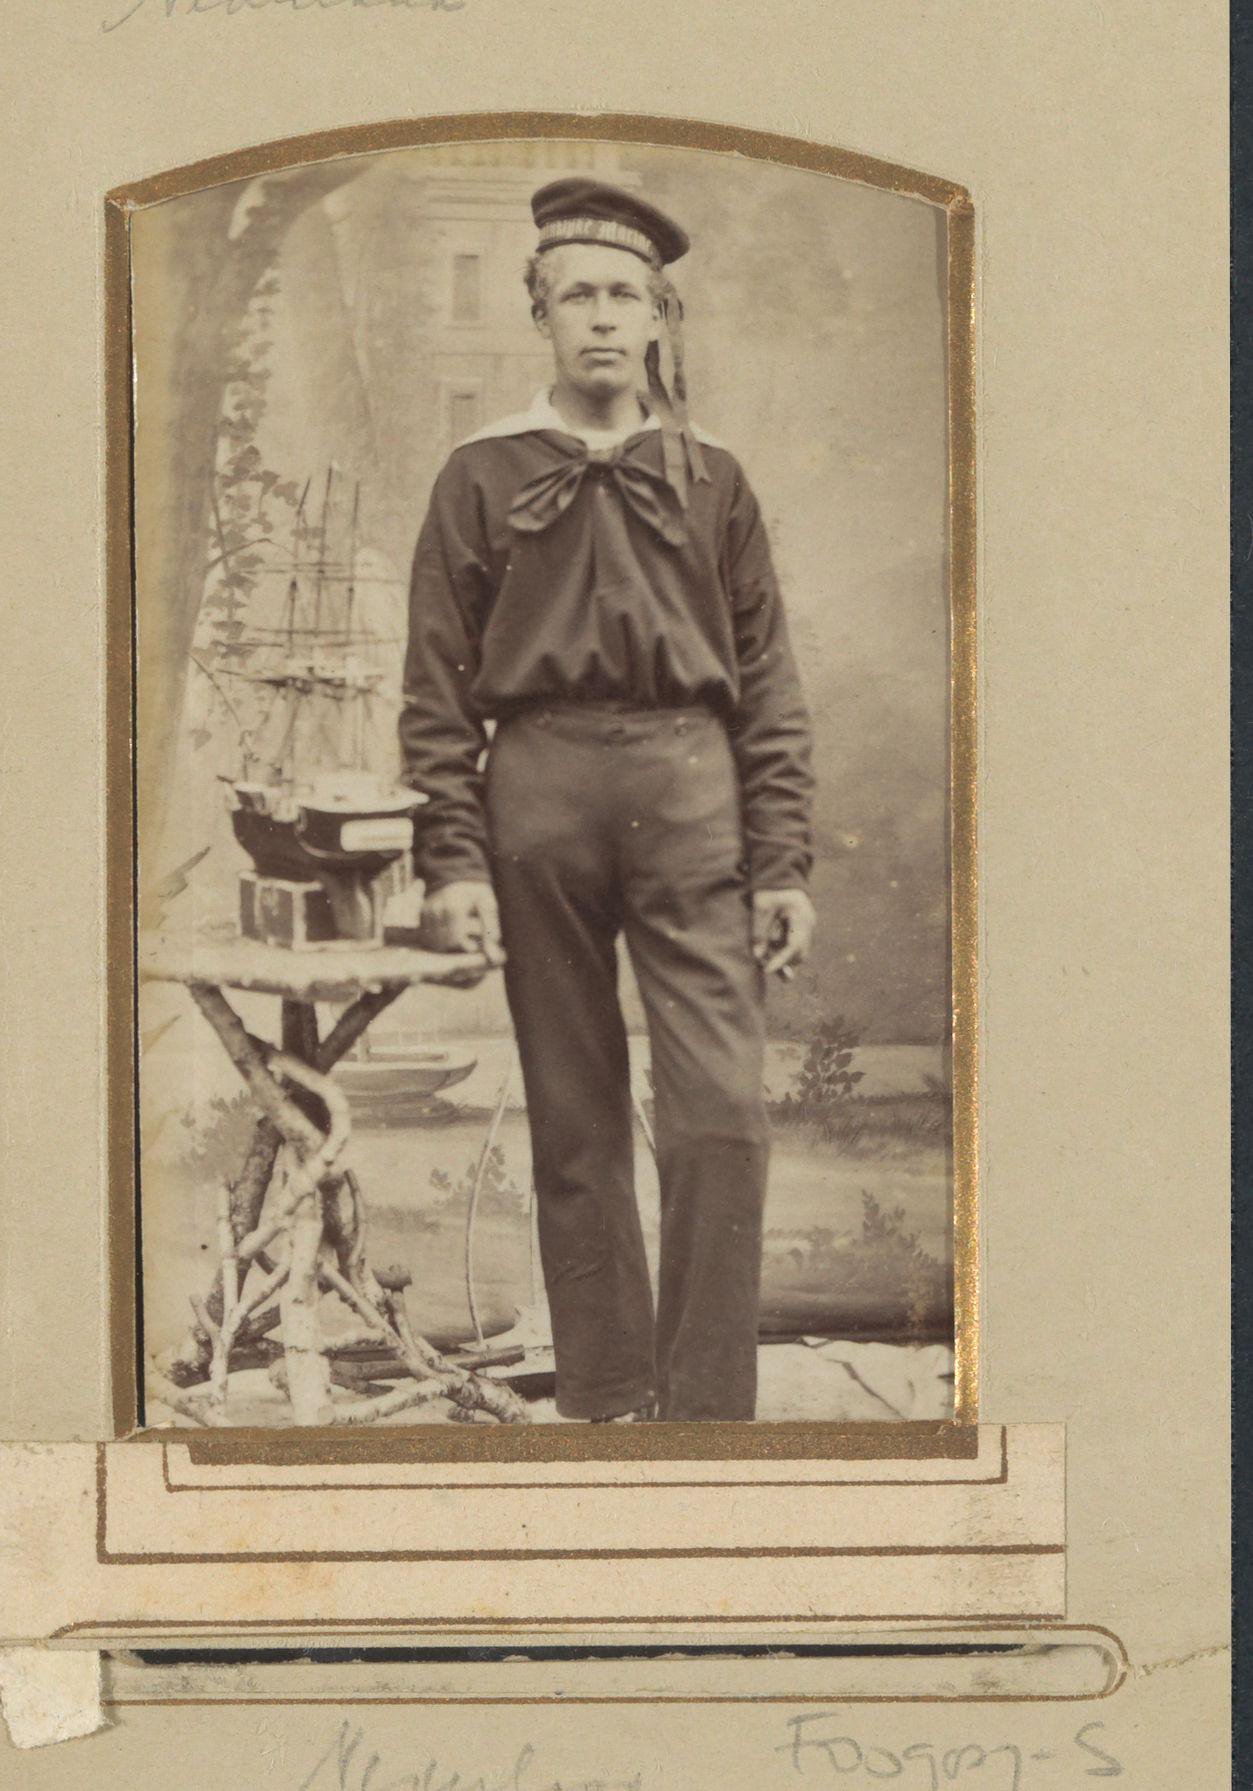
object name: album leaf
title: Portret van een matroos van de Koninklijk Marine, staand bij een scheepsmodel op tafel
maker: d. pigeaud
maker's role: fotograaf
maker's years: 1849-1886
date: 1878-1896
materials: cardboard, paper, photographic support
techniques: albumen print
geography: nieuwediep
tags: studio requisites ~ photographer, navy, warfare; military affairs, (military) uniforms, division of armed forces, ship-model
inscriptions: address: ‘Nieuwediep Hoofdgracht K 39’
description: Onderdeel van Album met cartes-de-visite en kabinetfoto's van militairen in uniform.